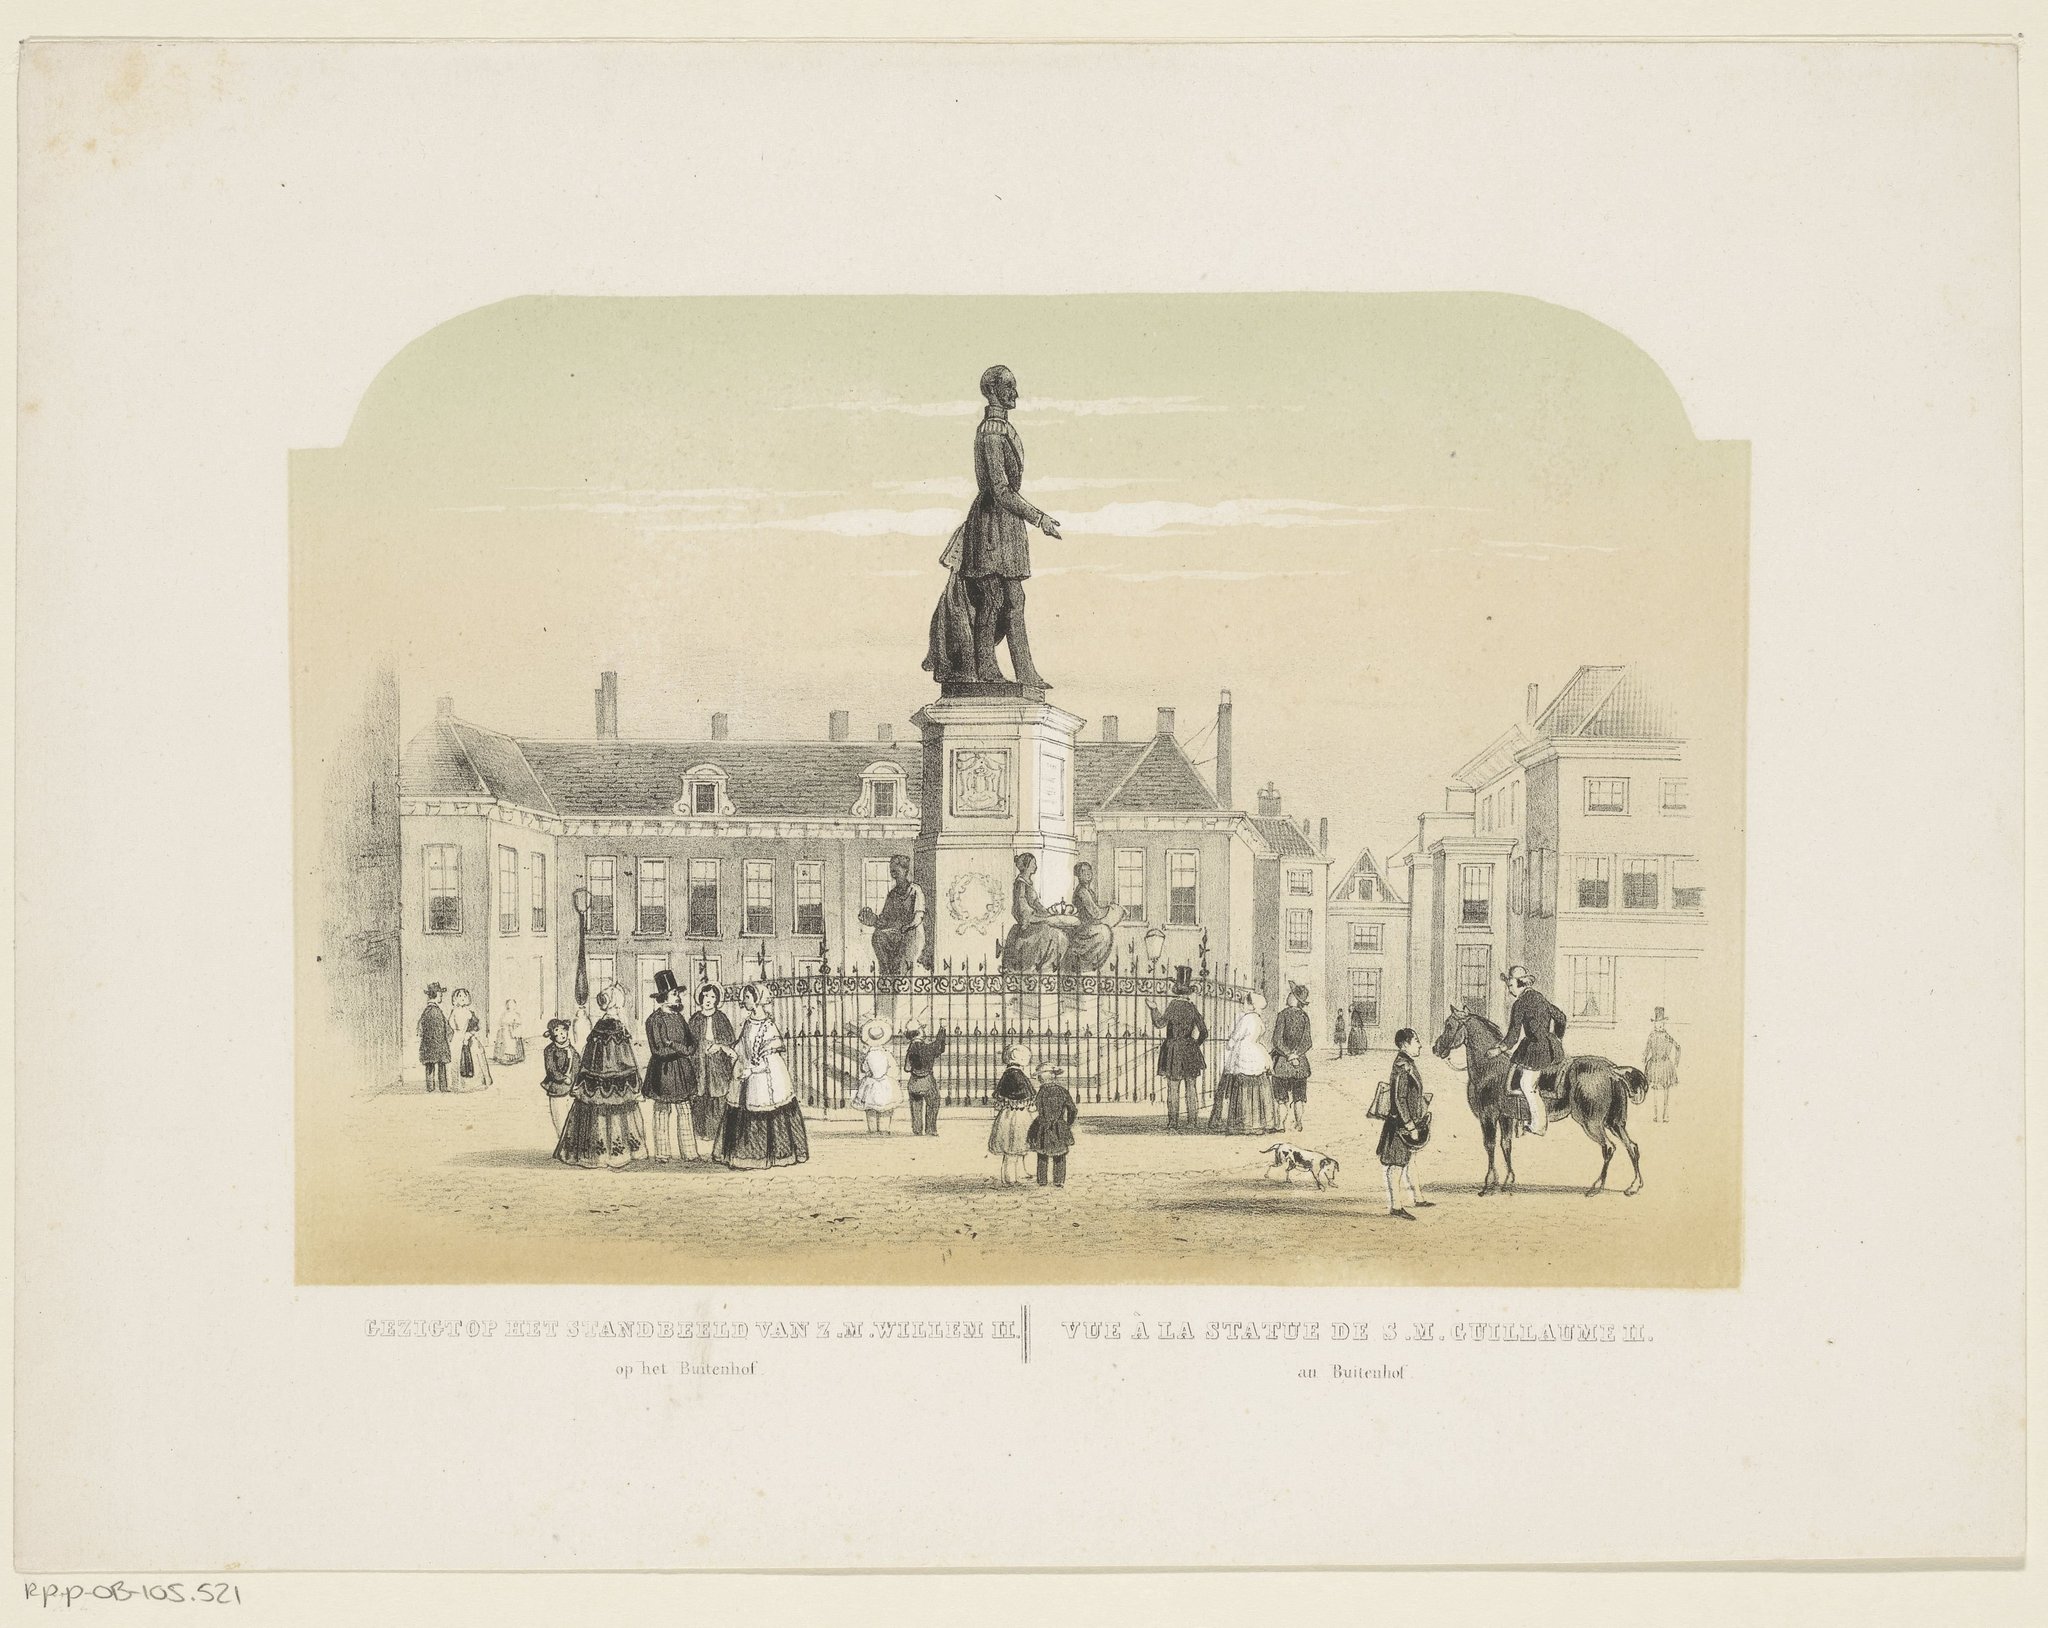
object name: print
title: Gezigt op het standbeeld van Z.M. Willem II, op het Buitenhof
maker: Anonymous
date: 1853-1949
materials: paper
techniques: lithograph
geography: netherlands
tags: william ii of the netherlands, monument, statue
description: De hier vermelde titel verwijst naar de hoogst verkregen titel van de geportretteerde, niet per se naar de titel die de geportretteerde op deze voorstelling draagt.